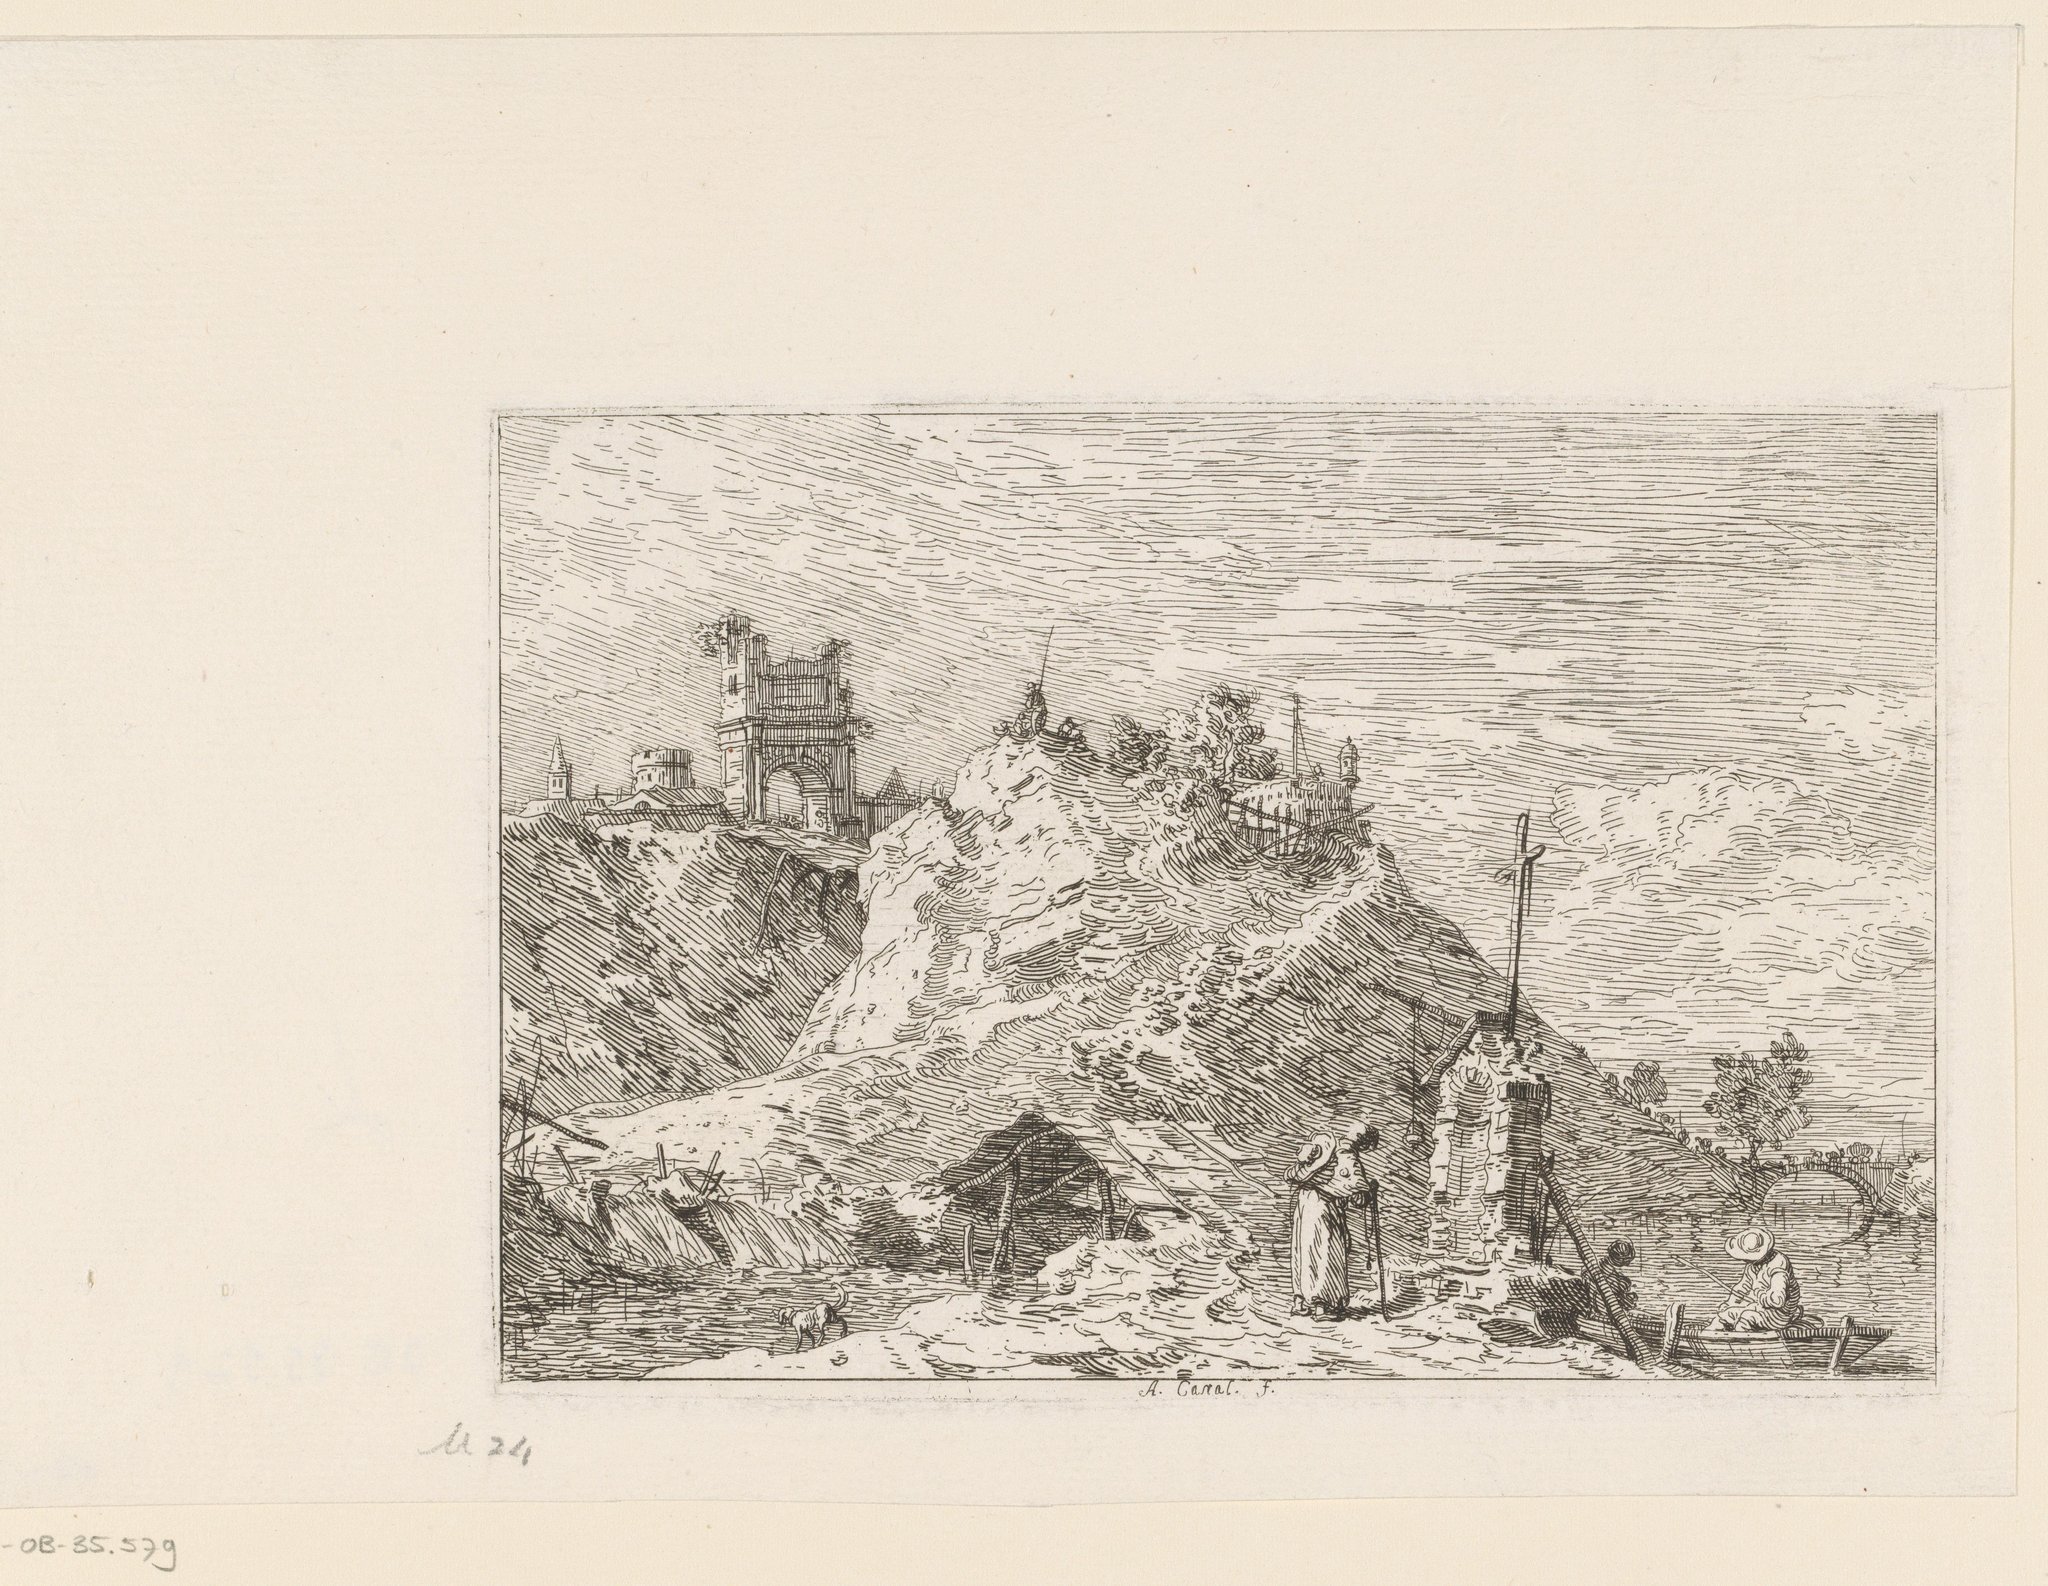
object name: print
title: Gezichten op bestaande en verzonnen plaatsen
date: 1707-1768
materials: paper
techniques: etching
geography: venice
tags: landscapes, pilgrim(s)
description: Een heuvellandschap met op de voorgrond een pelgrim voor een crucifix en twee vissers in een bootje. Op de heuvel links een ruïne.